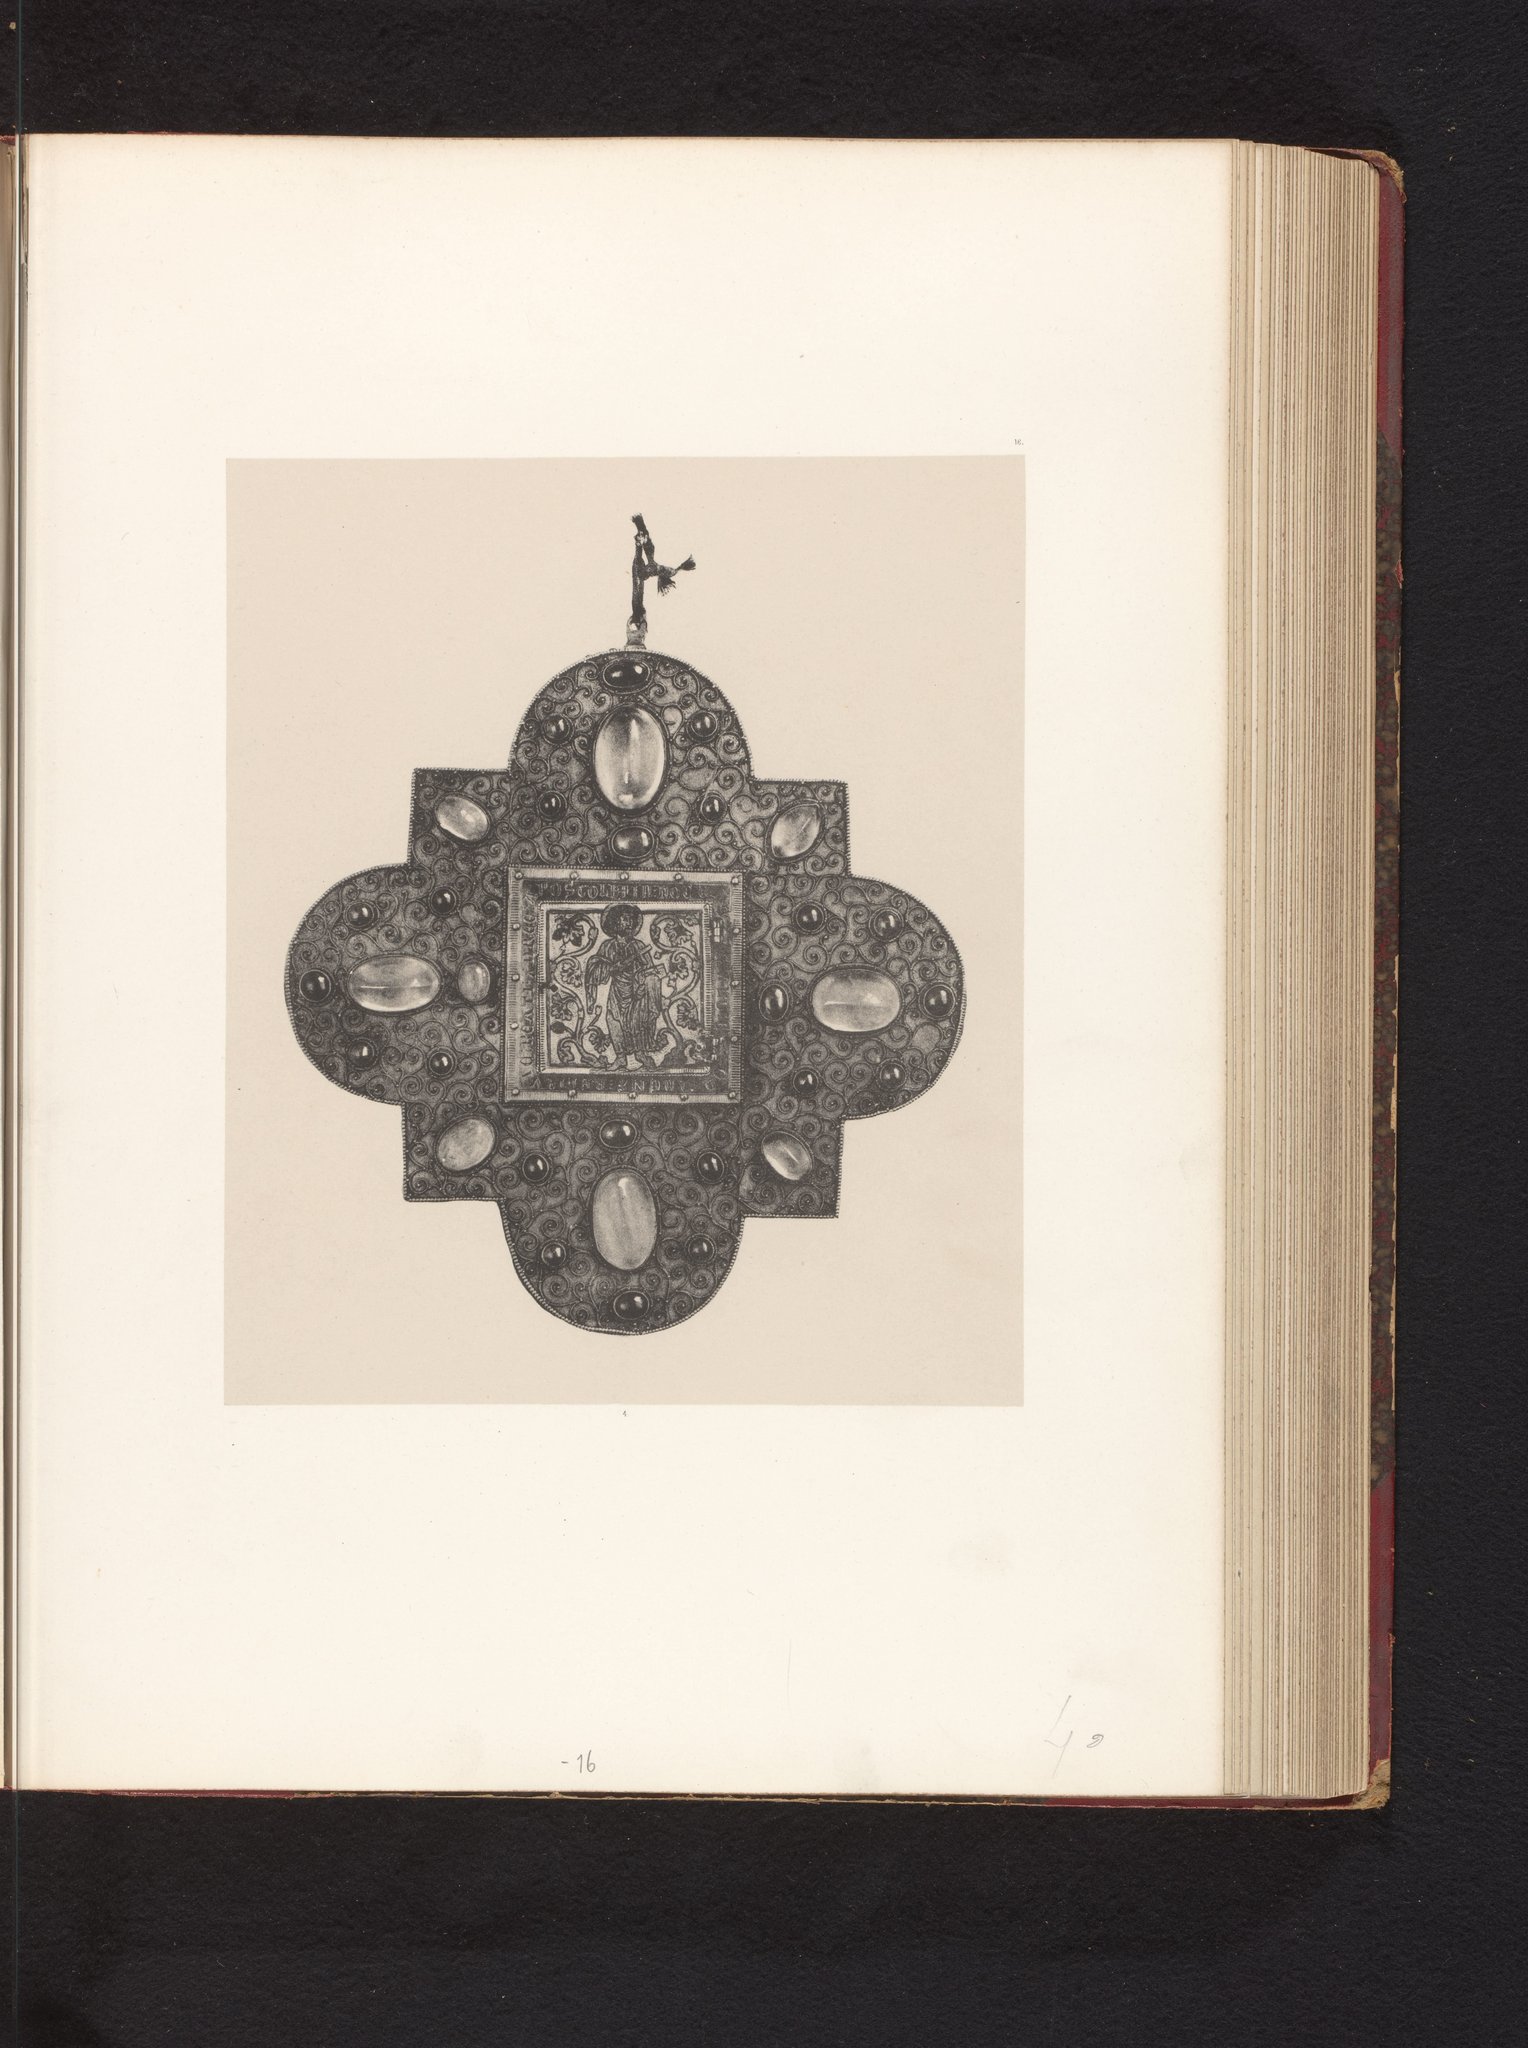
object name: page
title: Banderol van koper uit de collectie van de Soeurs de Notre-Dame de Namur, opgesteld op een tentoonstelling over religieuze objecten uit de middeleeuwen en renaissance in 1864 in Mechelen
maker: joseph maes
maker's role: fotograaf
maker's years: 1838-1908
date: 1864-1866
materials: paper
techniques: photolithography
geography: antwerp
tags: banderole, mechelen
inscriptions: number: ‘4’, number: ‘-16’, number: ‘4’